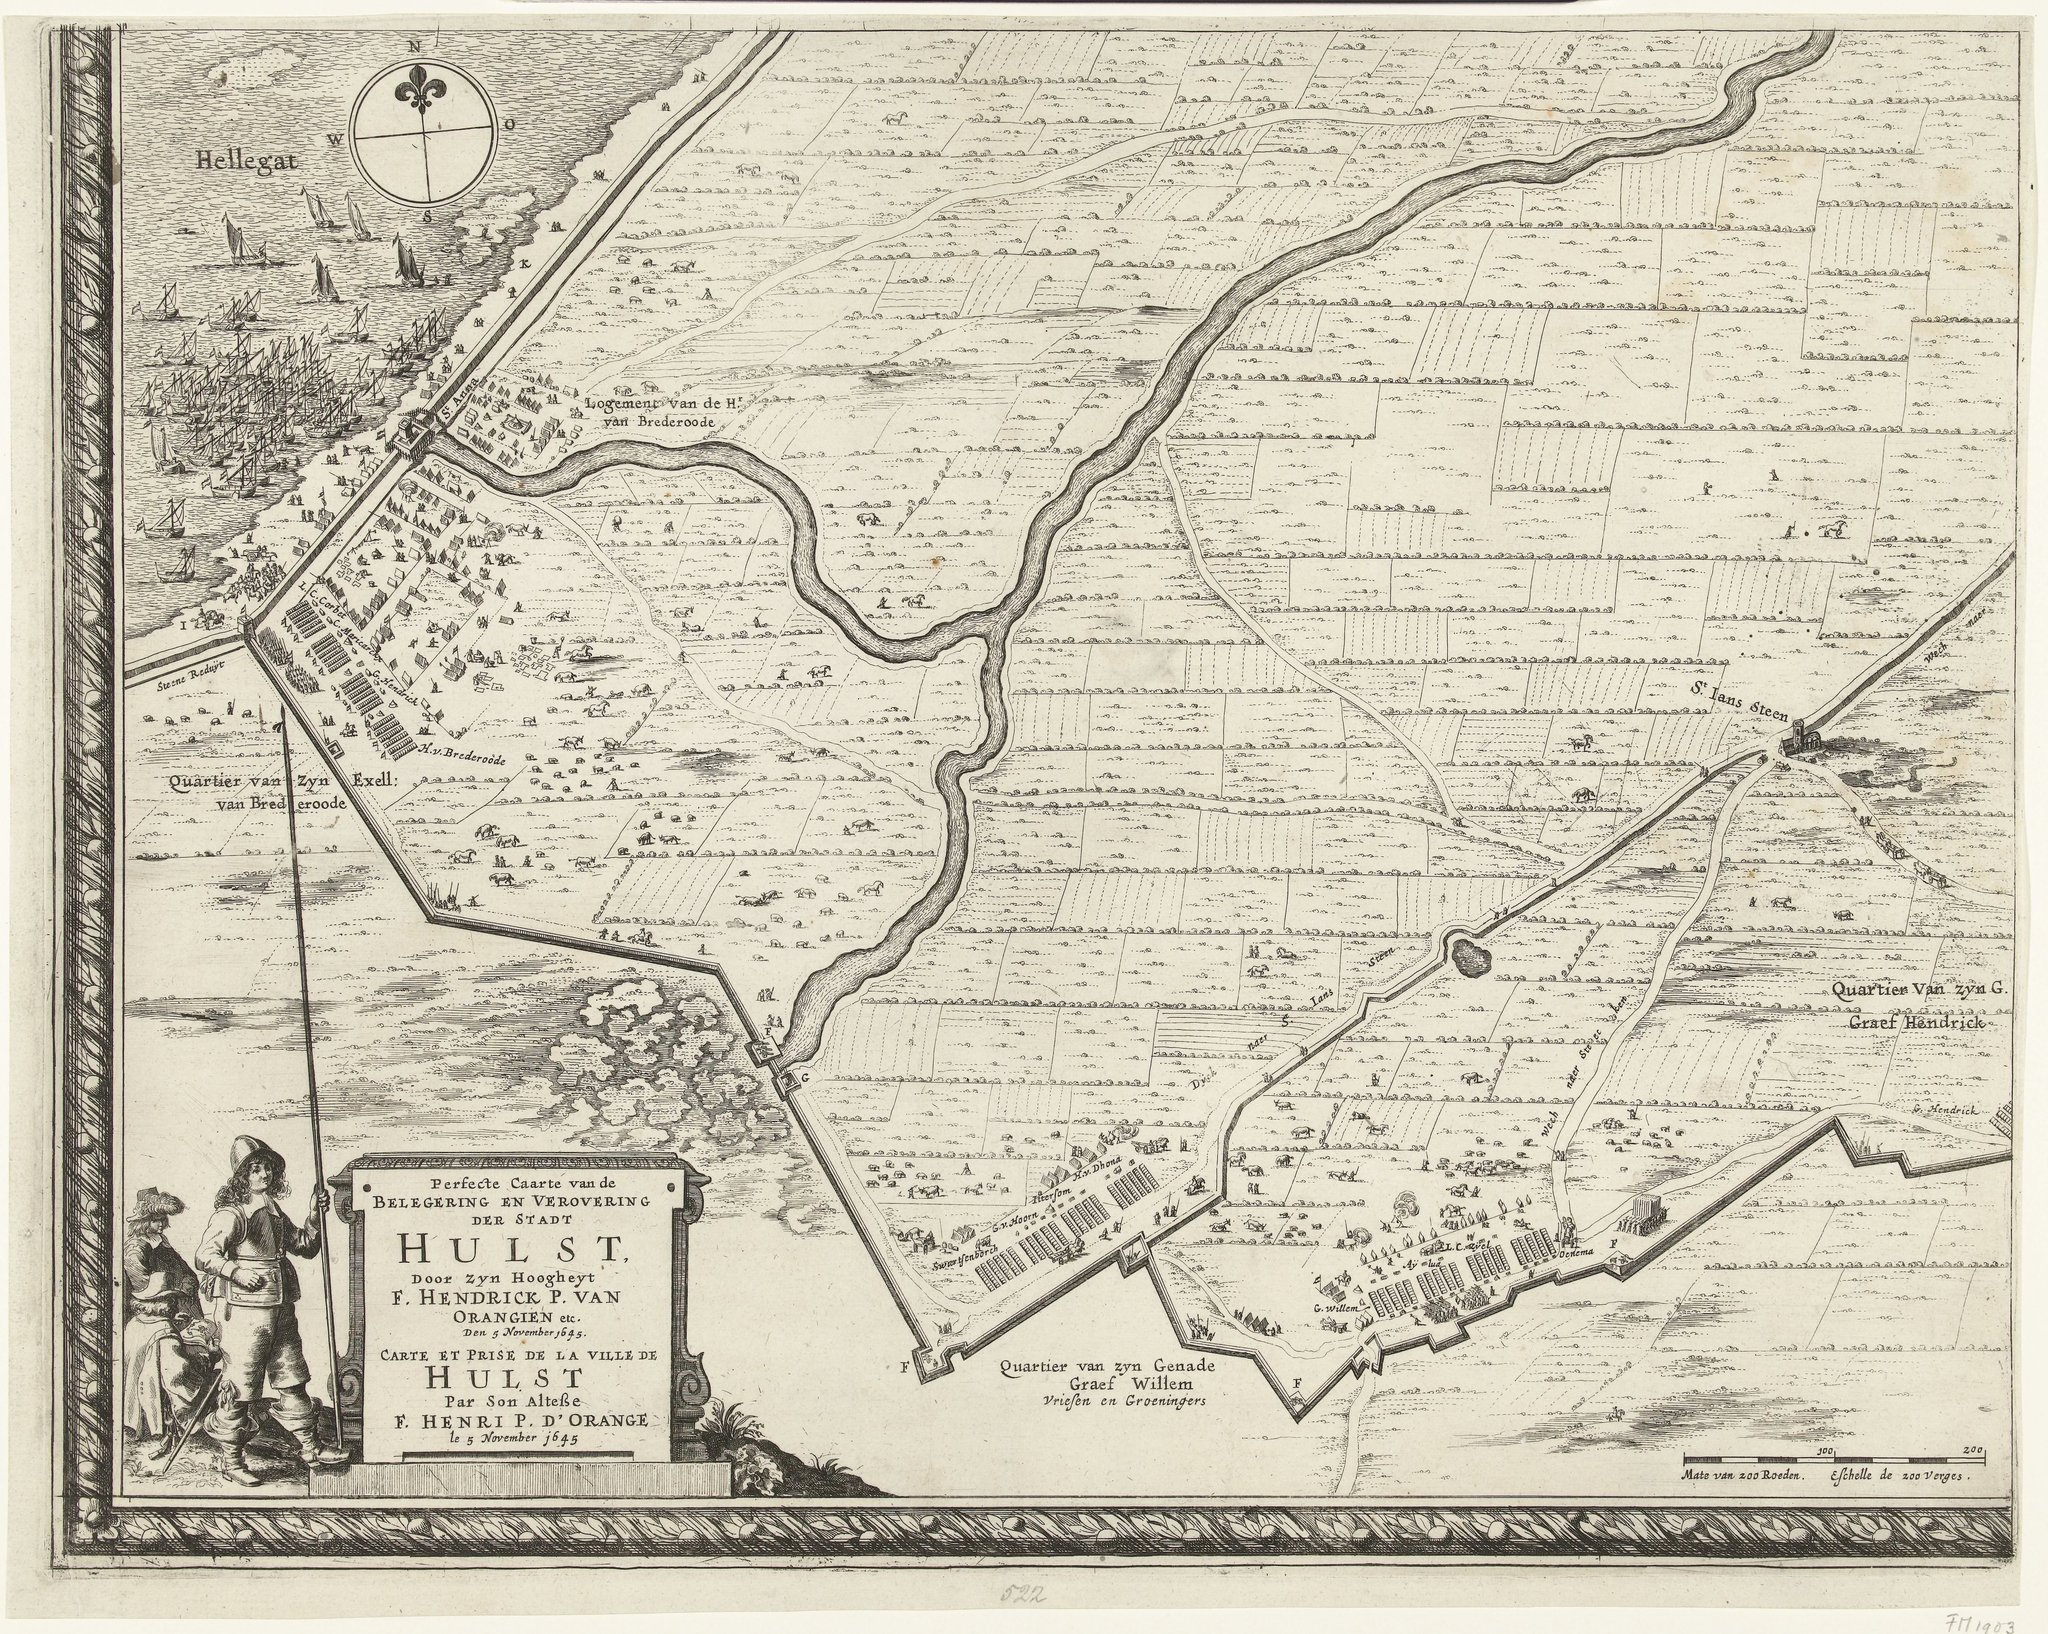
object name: map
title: Perfecte Caarte van de Belegering en Verovering der Stadt Hulst, Door zyn Hoogheyt F. Hendrick P. van Orangien etc. Den 5 November 1645 / Carte et Prise de la Ville de Hulst Par Son Altesse F. Henri P. d'Orange le 5 November 1645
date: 1646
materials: paper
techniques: etching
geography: breda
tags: frederick henry (prince of orange), fortress, maps of separate countries or regions, siege, position war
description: Beleg en verovering van Hulst door het Staatse leger onder Frederik Hendrik van 28 september tot 5 november 1645. Blad linksonder in de grote kaart. Kaart met belegeringswerken en de legerkampen van de belegeraars. Linksonder een cartouche met de titel en enkele soldaten. Onderdeel van een ongemonteerd ensemble bestaande uit de grote kaart van het beleg in 4 bladen, een tekstblad in het Frans (het tekstblad in het Nederlands ontbreekt) en de uittocht van het Spaanse garnizoen in 2 bladen.